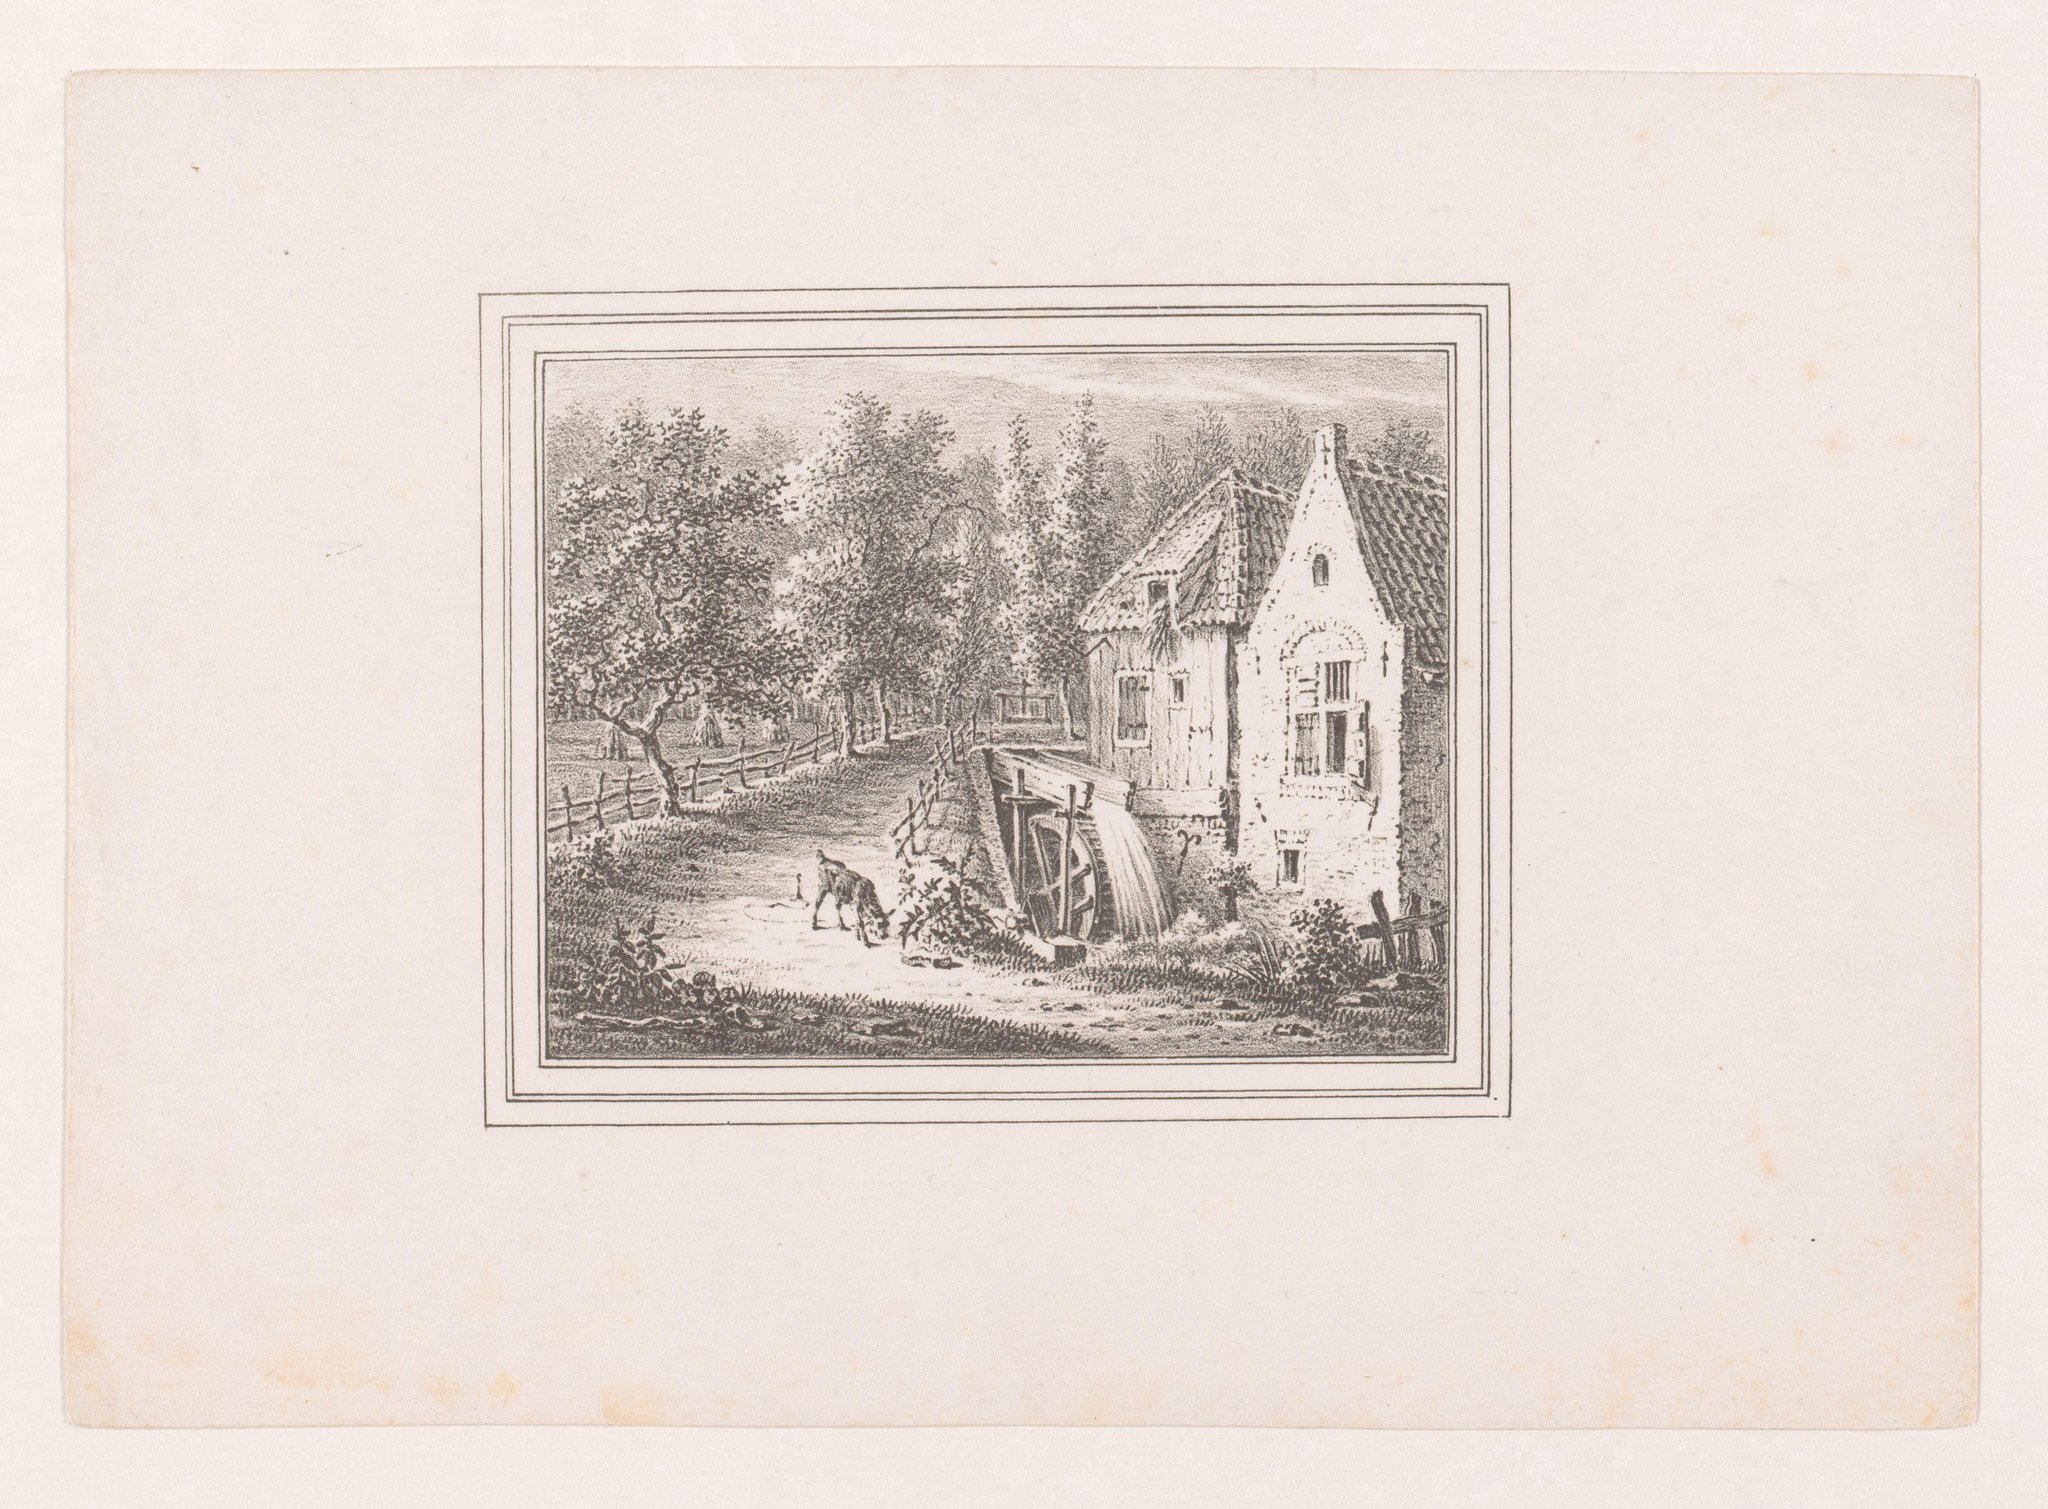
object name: print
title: Landschap met watermolen en een grazende geit aan een touw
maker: pieter de goeje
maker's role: draughtsman, print maker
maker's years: 1789-1859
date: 1825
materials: paper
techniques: lithograph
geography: netherlands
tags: agricultural products and by-products: hay (+ harvesting ~ agricultural processes), watermill in landscape, goat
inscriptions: collector's mark: Lugt 2228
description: RP-P-OB-28.320 en RP-P-1944-357 laten dezelfde voorstelling zien. Deze verschilt in details met RP-P-1937-819 en RP-P-1905-3203.